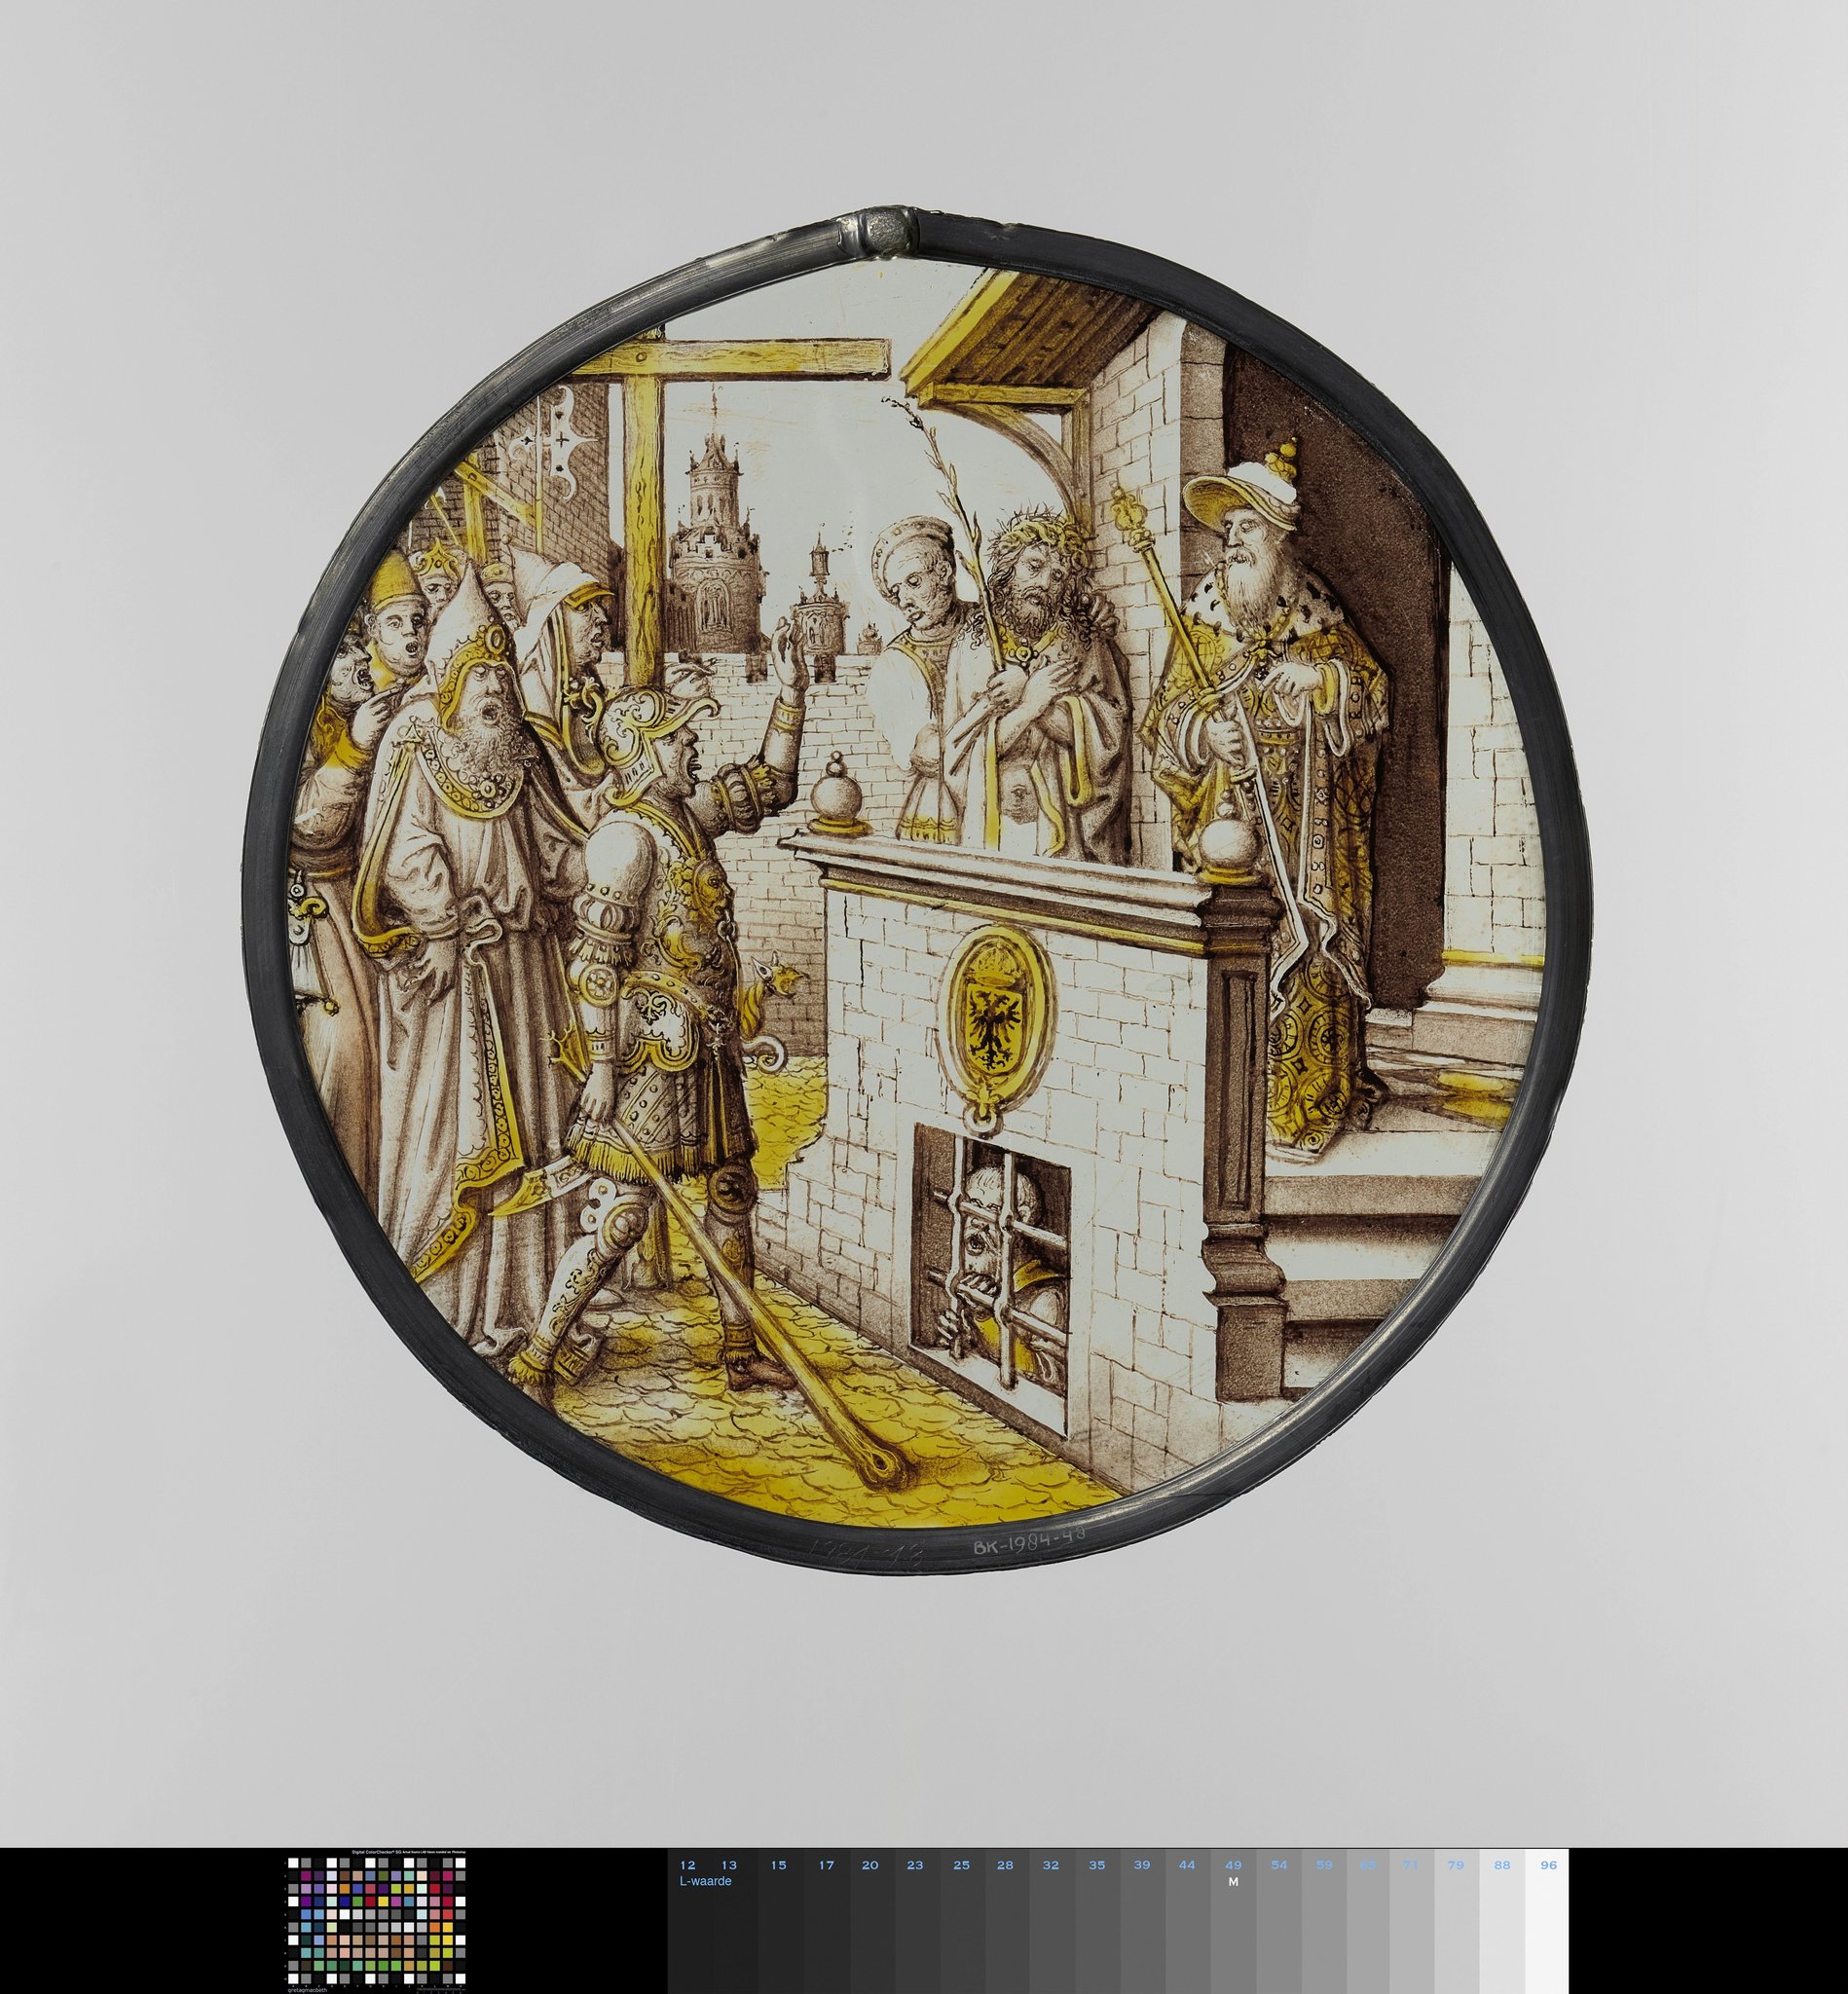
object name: light window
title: Ruit met Ecce Homo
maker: Anonymous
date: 1510-1530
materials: glass, lead, pigment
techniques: leading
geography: southern netherlands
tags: pilate showing christ to the people, 'ostentatio christi', 'ecce homo' (john 19:4-6)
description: The Mocking of Christ. Stained glass. Netherlands, c. 1515.